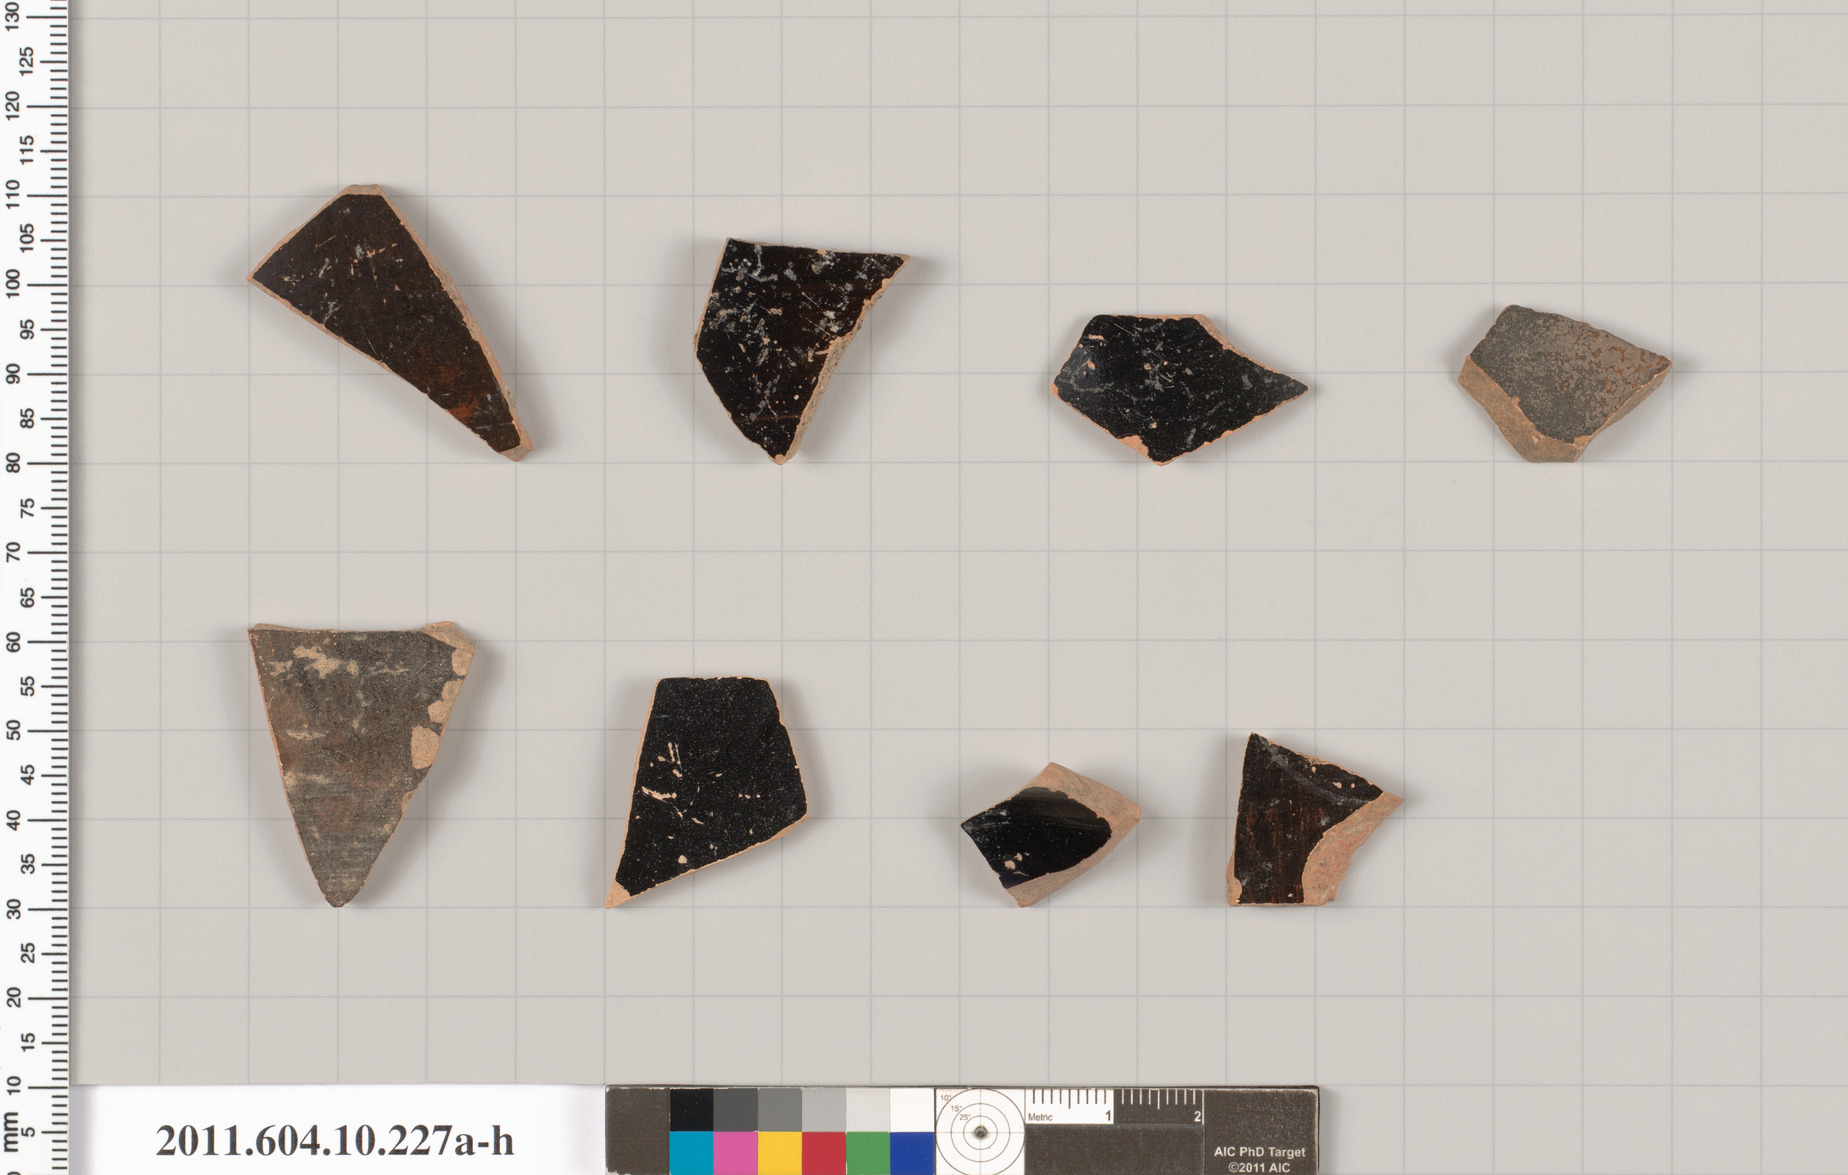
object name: undetermined closed shape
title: Terracotta fragments of closed shapes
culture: etruscan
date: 601-700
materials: terracotta